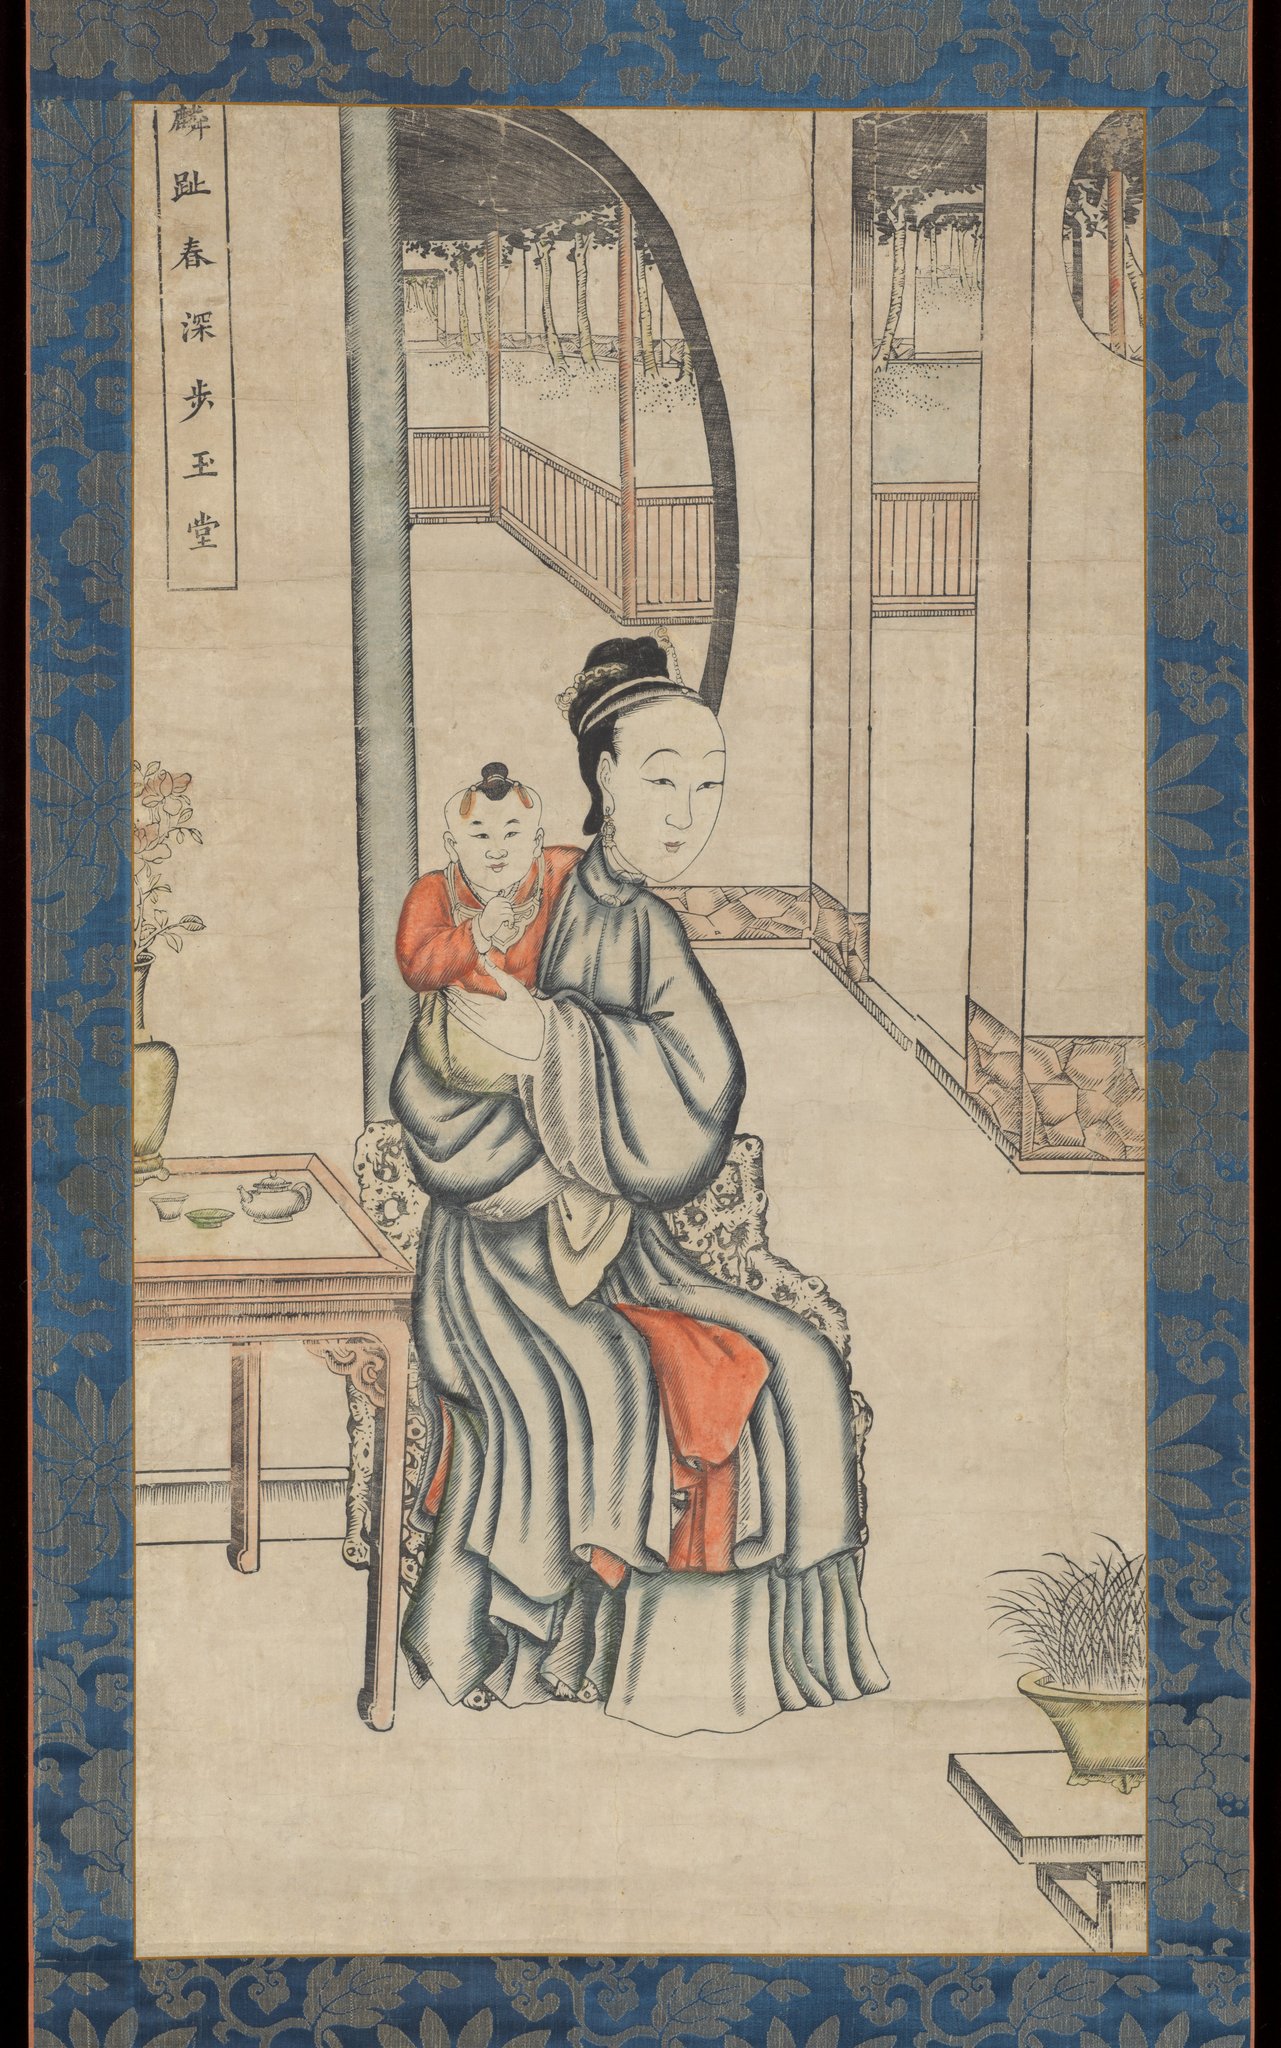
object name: print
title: Mother and Child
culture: chinese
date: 1736-1795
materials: ink, paper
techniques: hand coloring, woodblock print